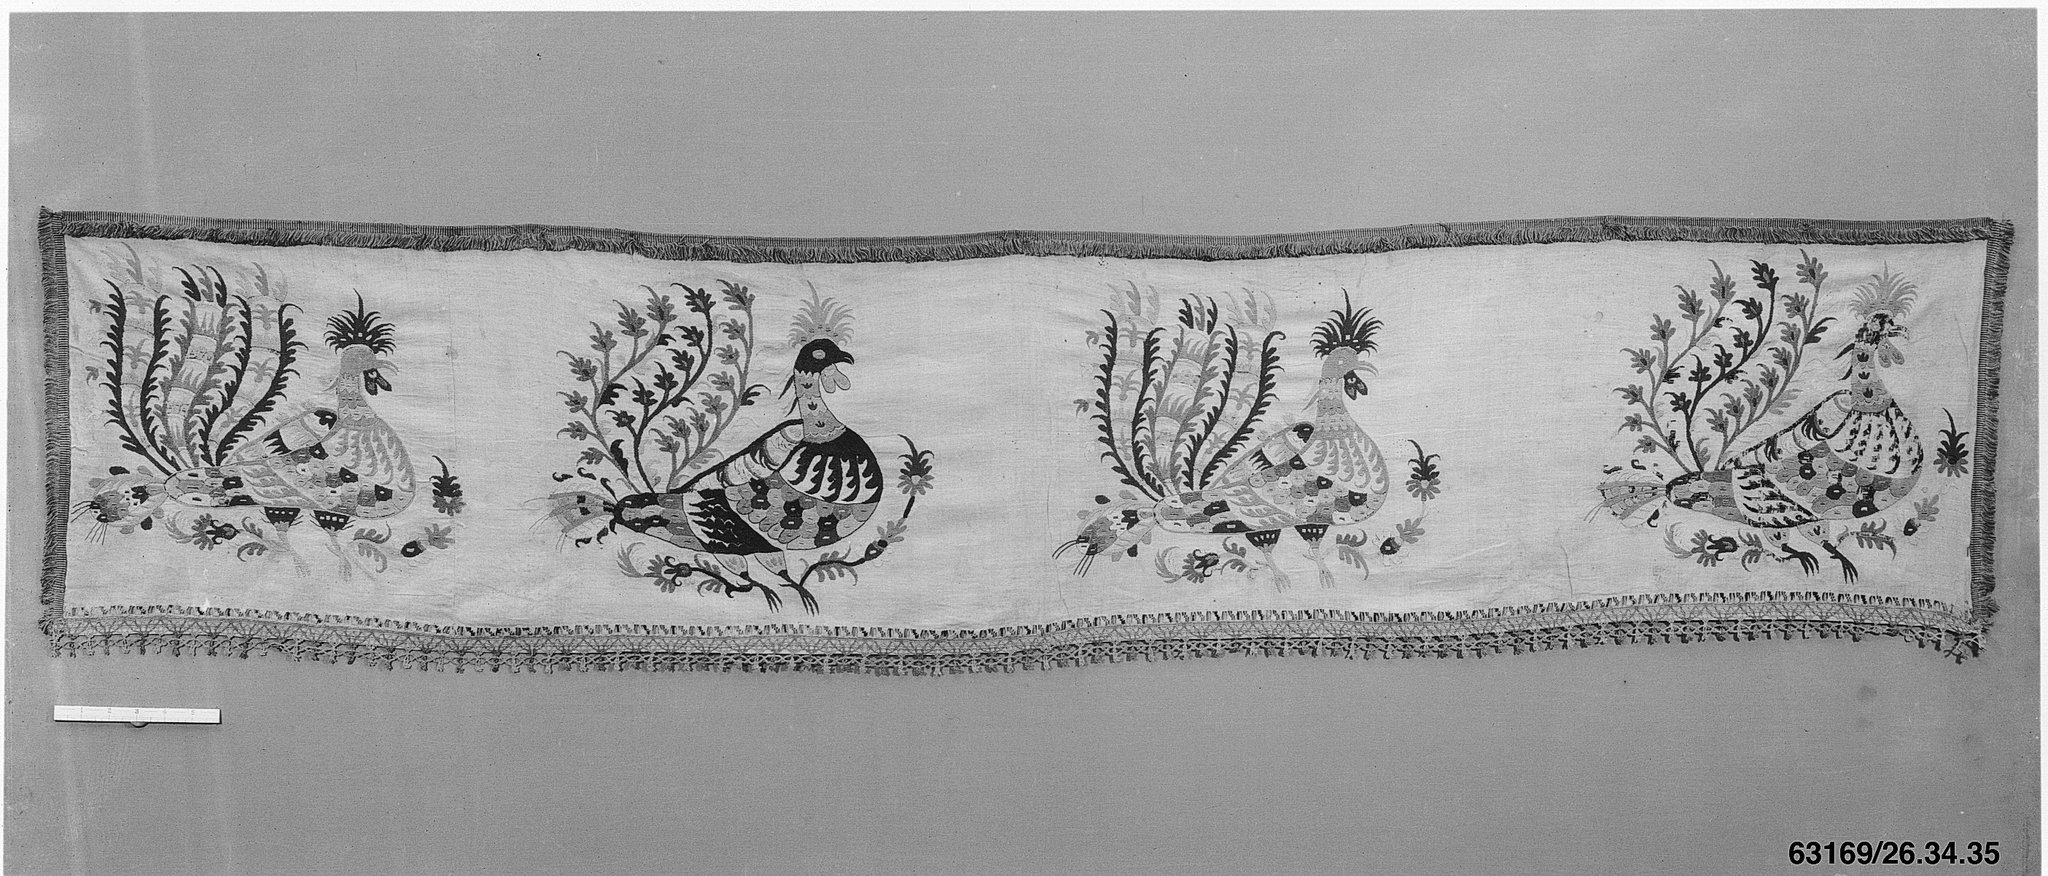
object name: fragment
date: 1701-1800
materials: linen, silk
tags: birds